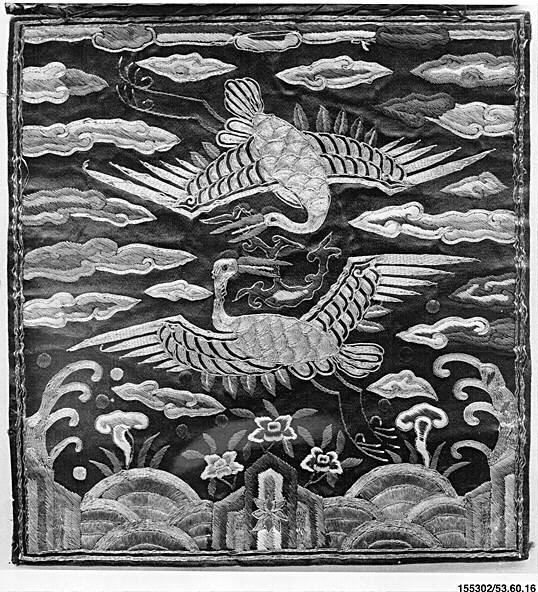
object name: rank badge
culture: korean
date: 1392-1910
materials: silk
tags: cranes